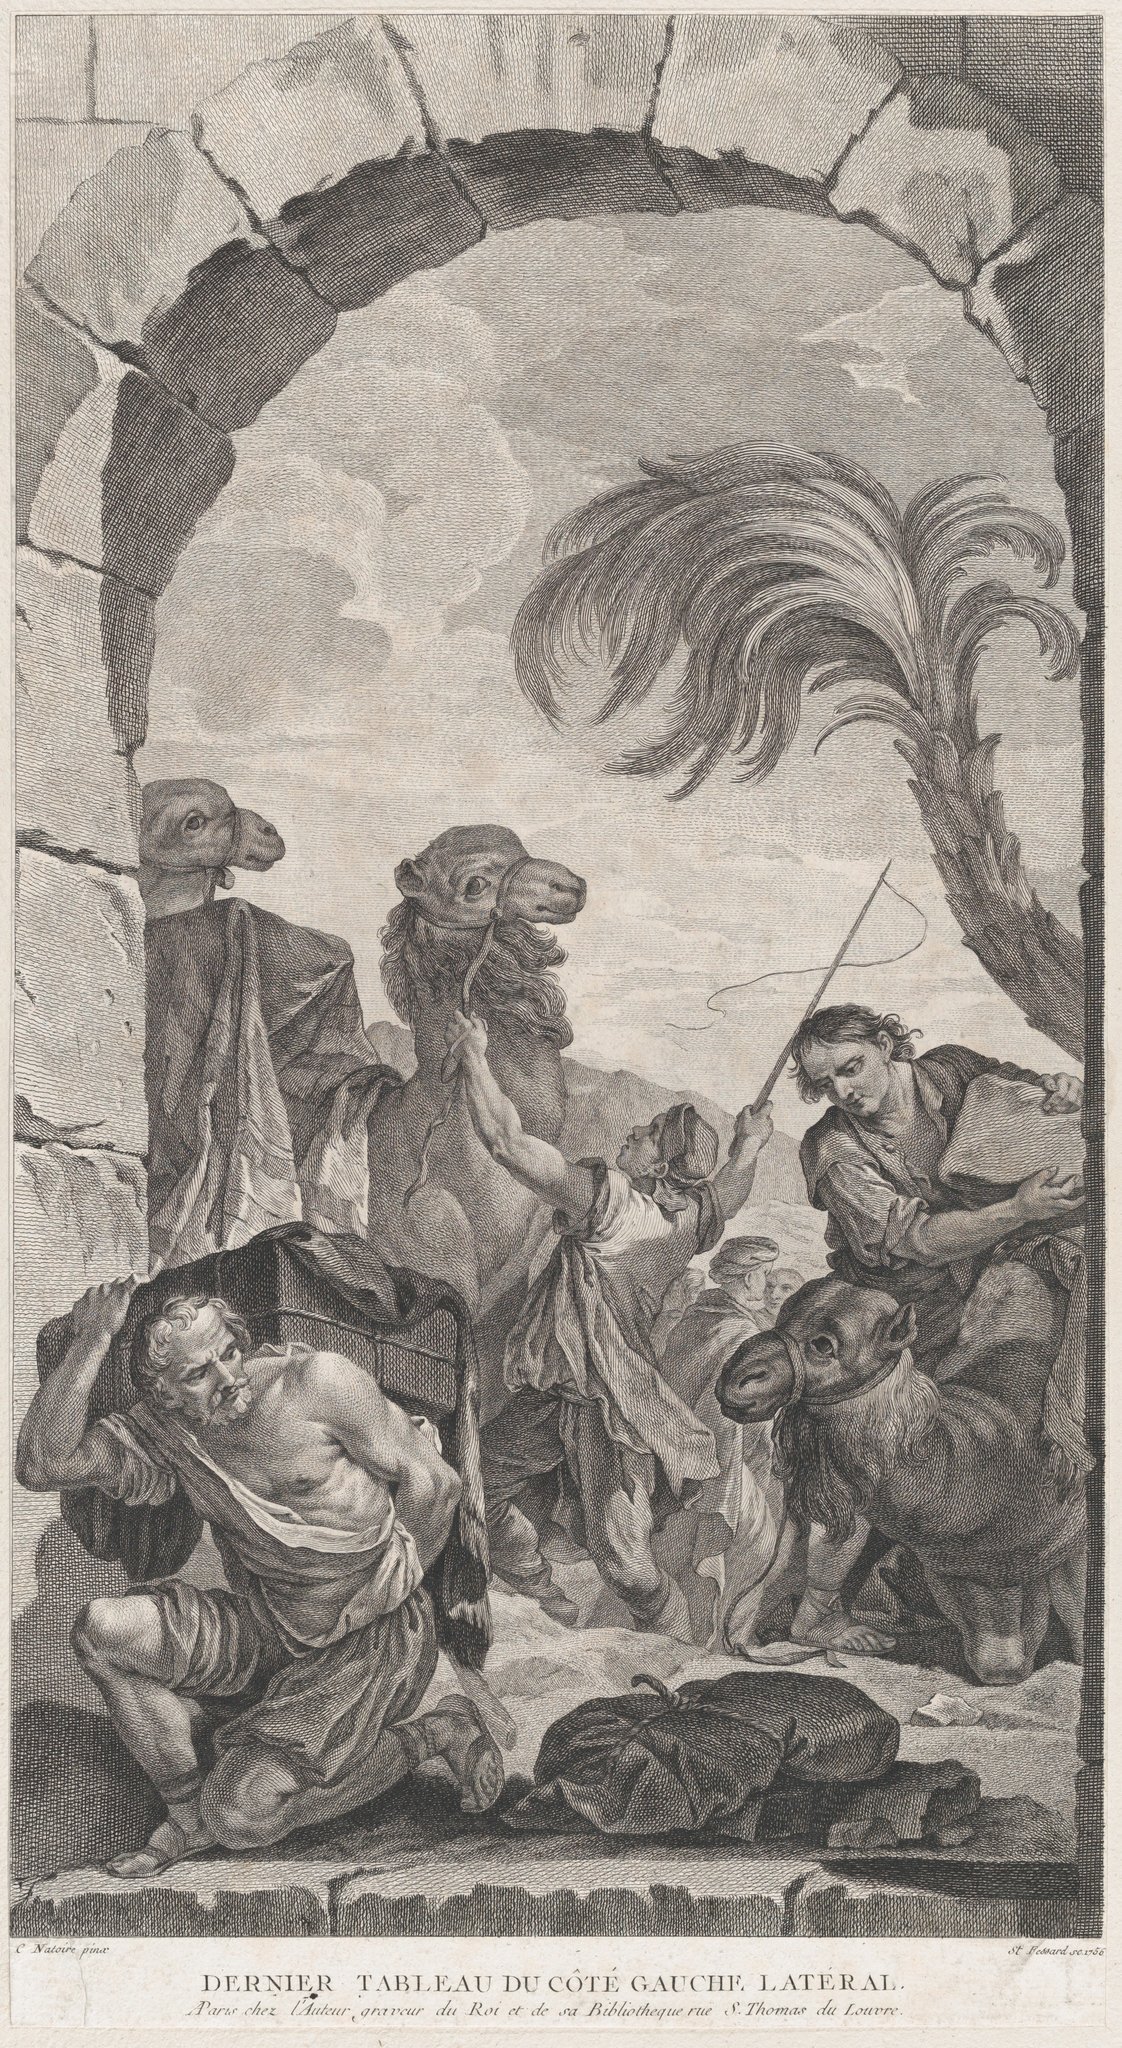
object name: print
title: The Chapel of the Enfants-Trouvés in Paris: La Suite des rois mages: chameliers et porteurs de présents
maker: etienne fessard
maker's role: artist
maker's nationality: french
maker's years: 1714-1777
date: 1756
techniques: engraving, etching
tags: men,camels